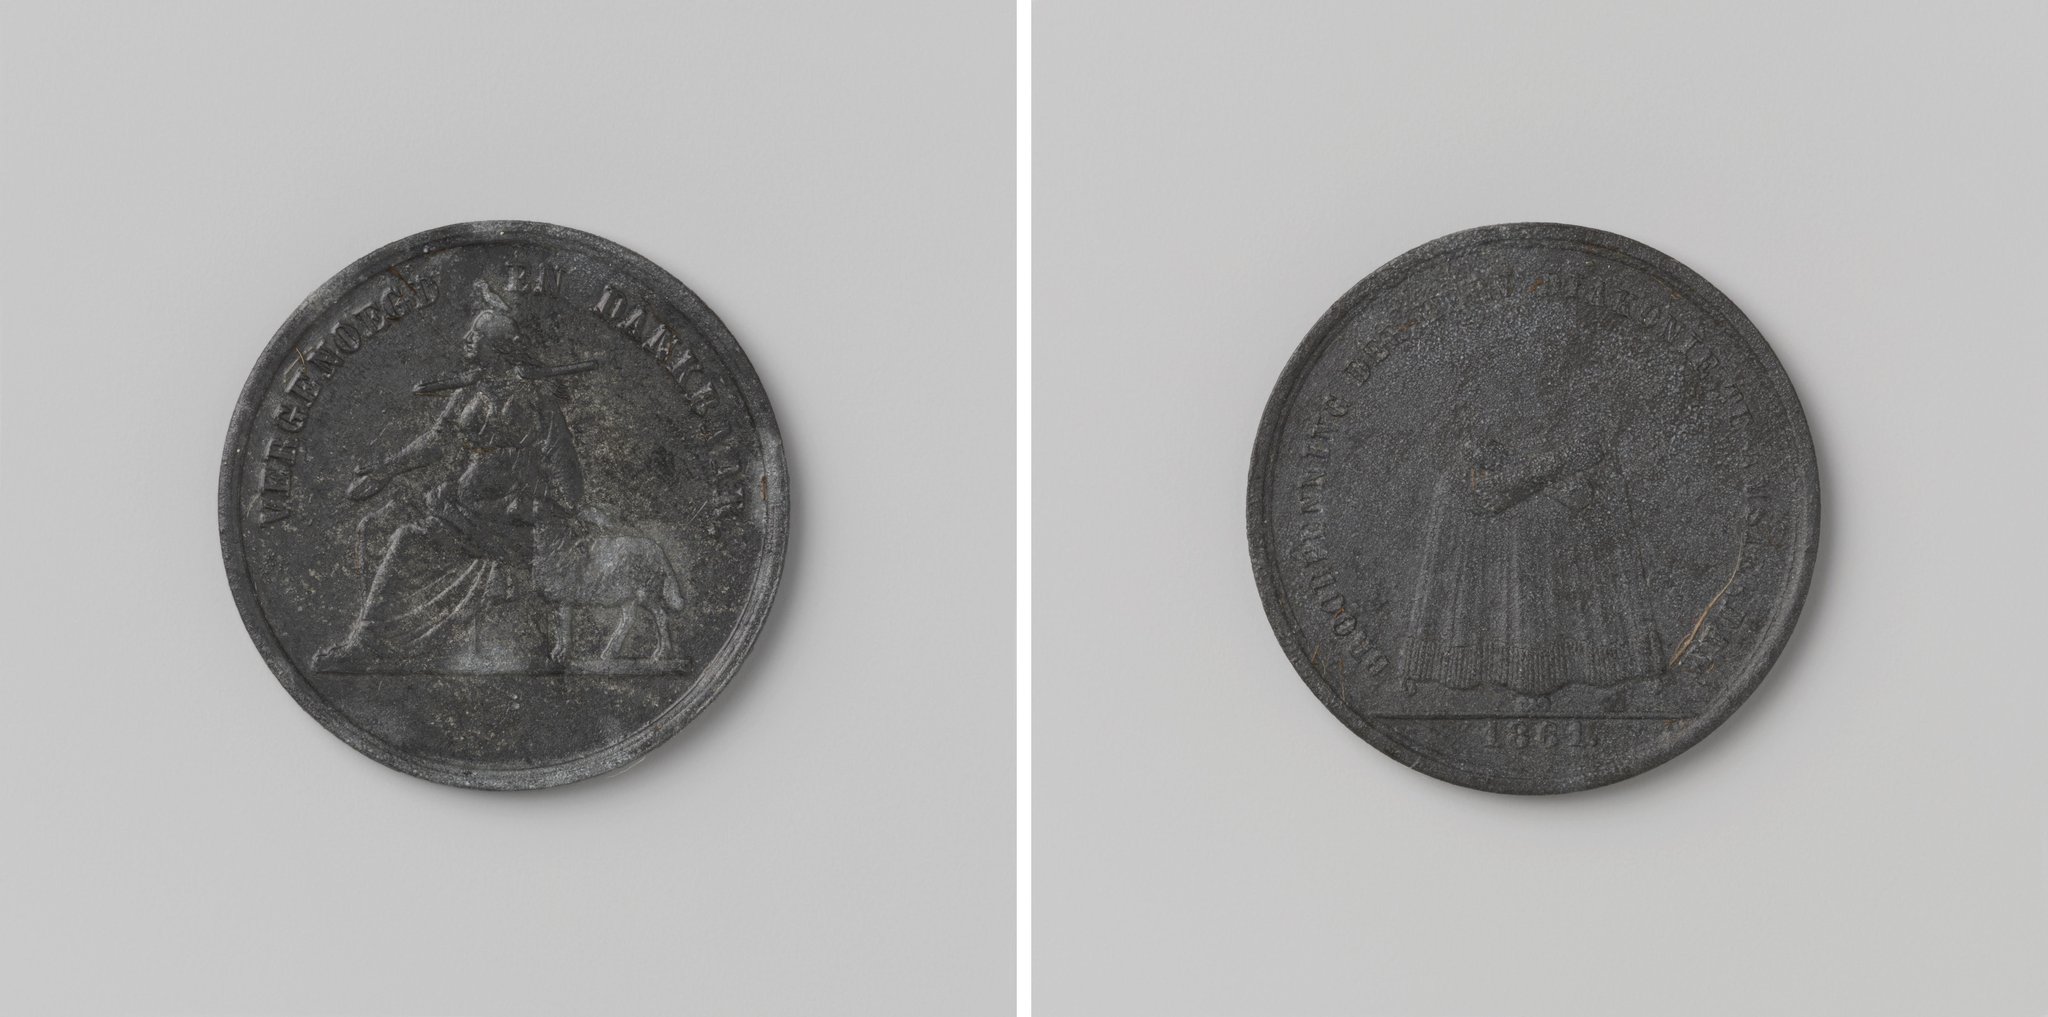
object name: armenloodje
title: Hervormde Diakonie te Amsterdam, loodje dat behoeftige kerklidmaten bij uitdeling recht gaf op brood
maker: david van der kellen (1804-1879)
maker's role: die cutter, draughtsman, print maker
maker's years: 1804-1879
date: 1861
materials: silver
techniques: striking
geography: amsterdam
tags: amsterdam